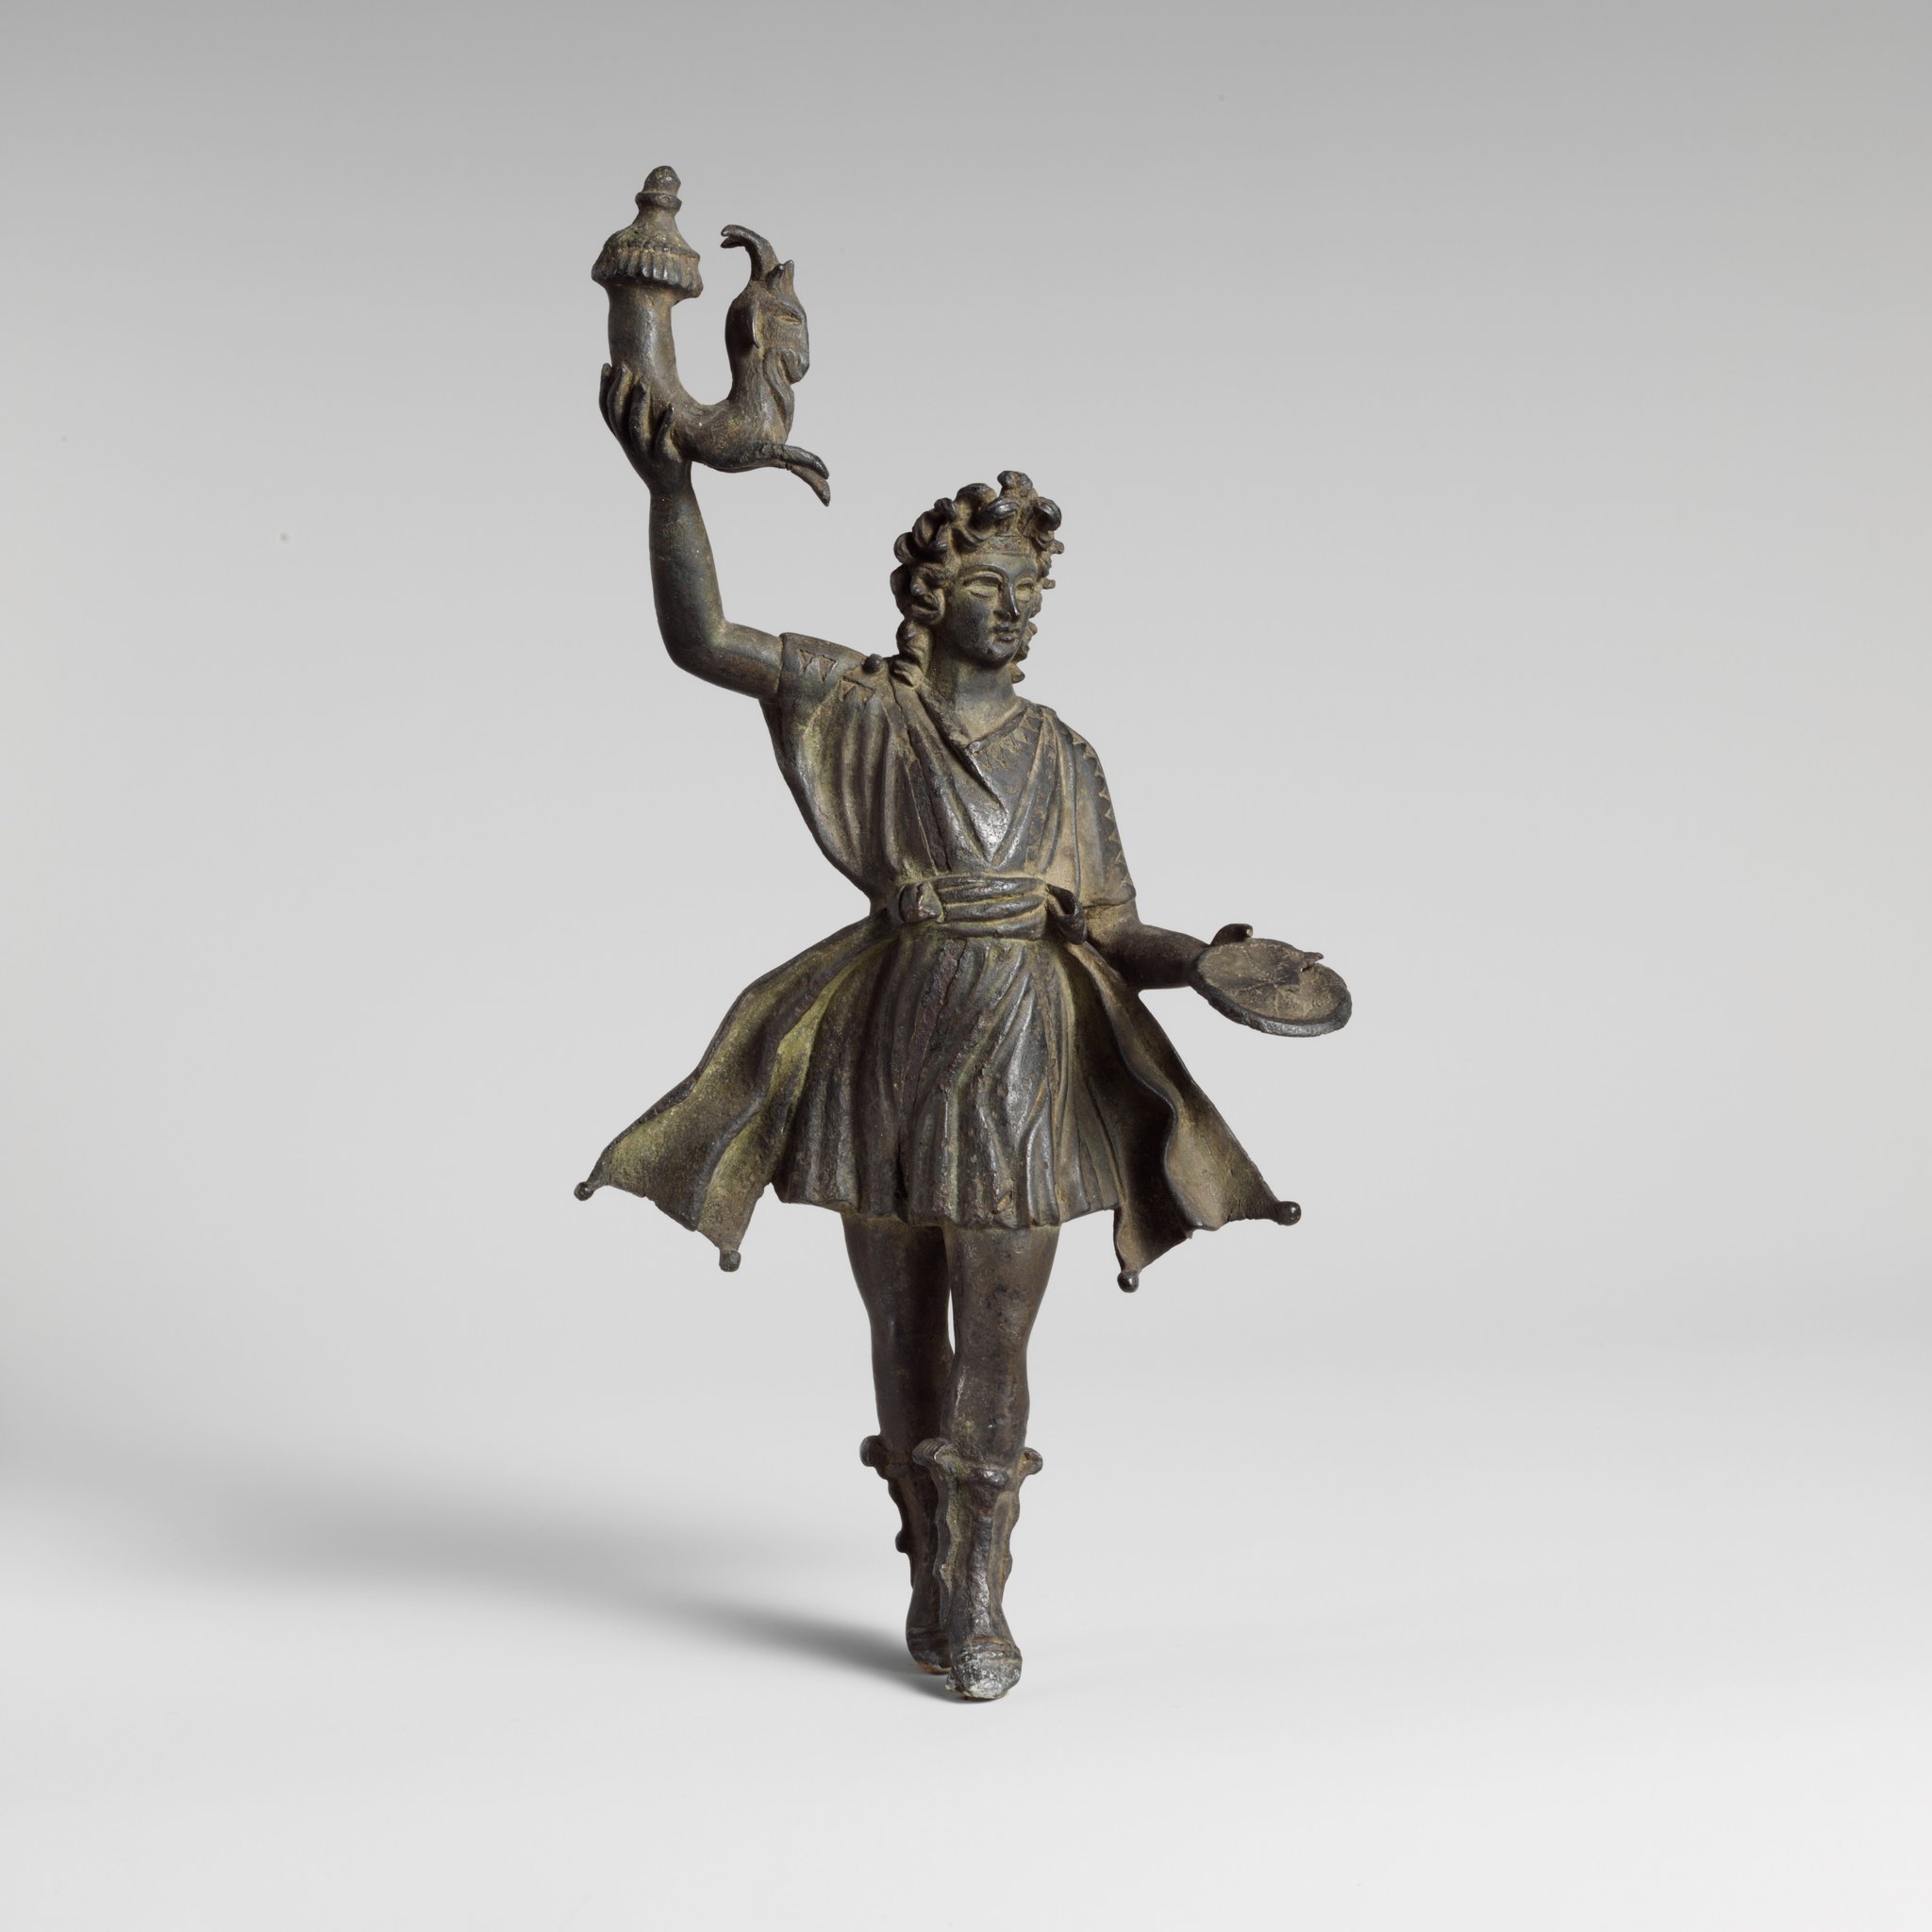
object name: statuette of a lar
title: Bronze statuette of a Lar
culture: roman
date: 1-200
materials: bronze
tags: women